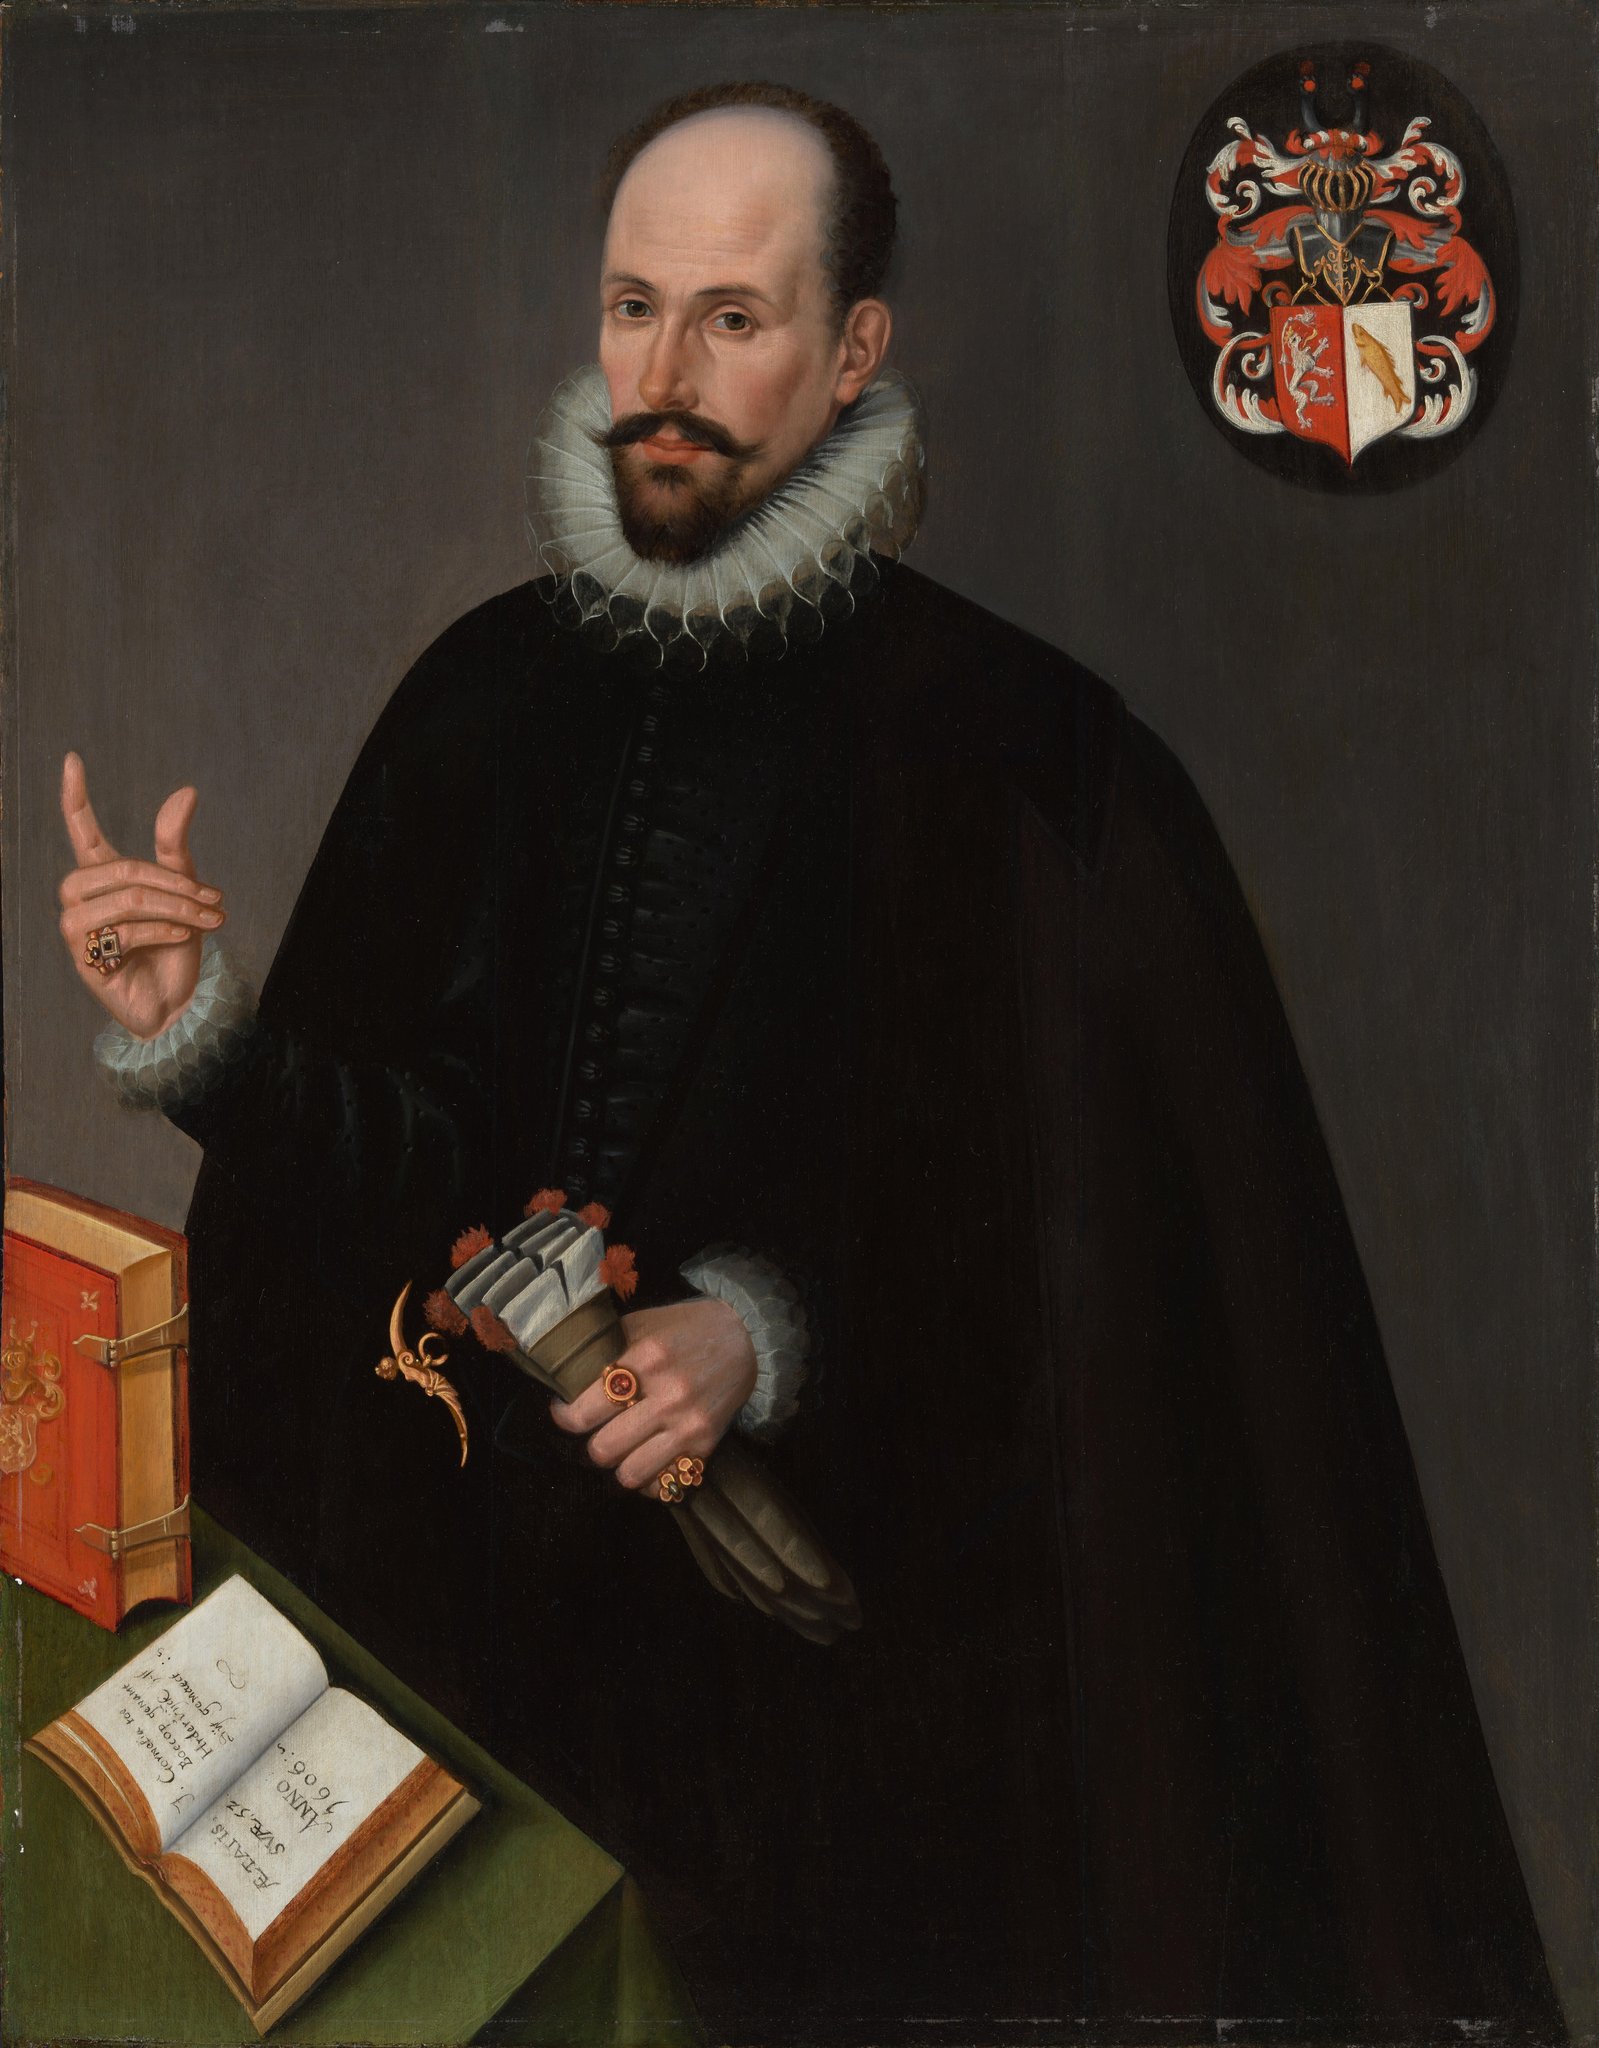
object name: painting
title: Portret van Ott van Bronckhorst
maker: cornelia toe boecop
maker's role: painter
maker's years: 1551-1629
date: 1606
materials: oil, paint, panel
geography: kampen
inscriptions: inscription: ‘J. Cornelia toe/ Boecop genamt/ Hrderúijk heft/ dijt gemaect:s ∞’, inscription: ‘AETATIS/SVAE/ANNO 1606’, coat of arms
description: Ott van Bronckhorst staat voor een grijze achtergrond, voor hem een schuine tafel met groen tafellaken, daarop een opengeslagen boek. Op de bladzijden staat: heraldisch links: AETATIS/SVAE/ANNO 1606: heraldisch rechts: J. Cornelia toe/ Boecop genamt/ Hrderúijk heft/ dijt gemaect:s ∞ . Rechts boven zijn wapenschild.